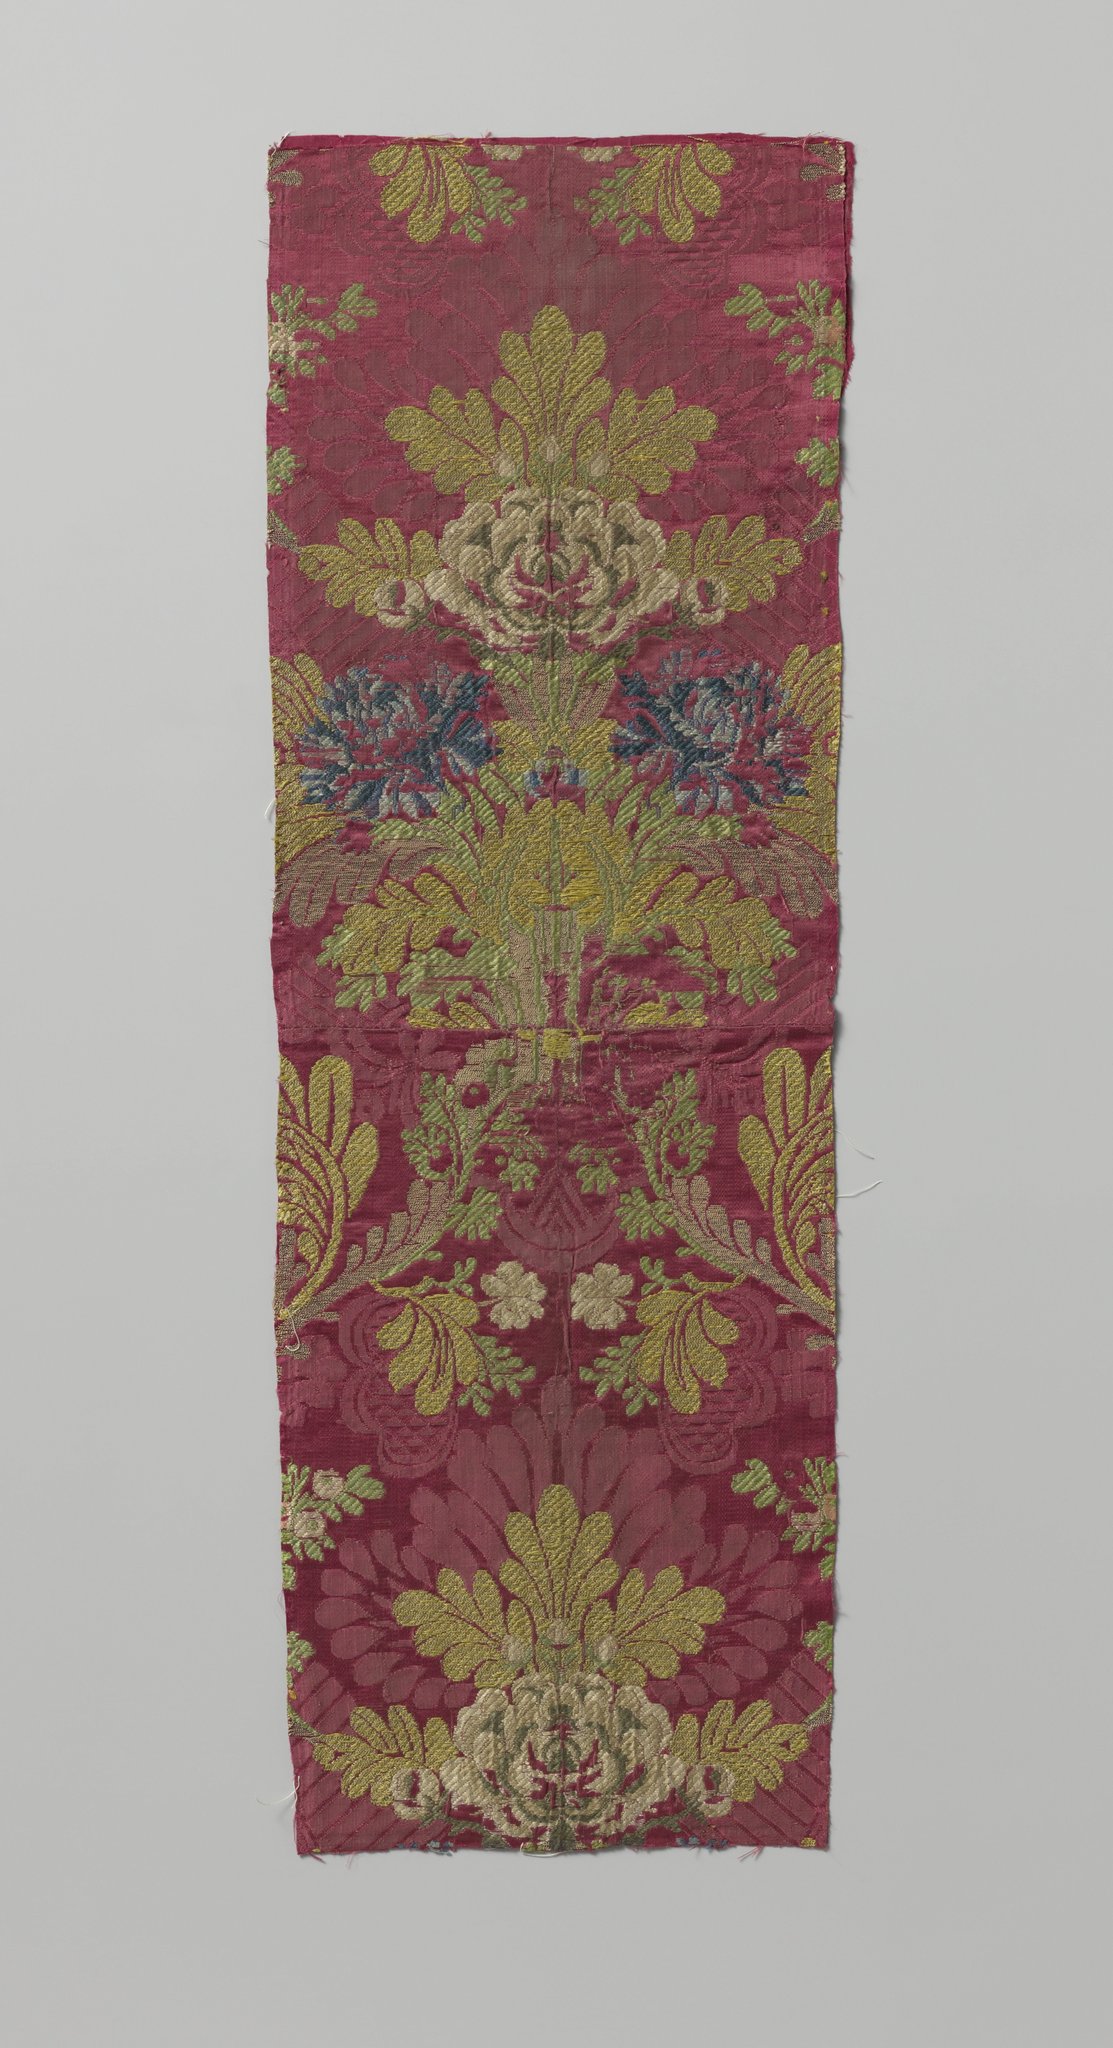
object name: zijdedamast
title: Fragment van een veelkleurig zijdedamast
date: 1740-1760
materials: silk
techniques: brocade, damask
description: Op een rode satijnen grond een symmetrische tak goud of zilver doorweven bladeren, twee blauwe anjers en een licht-zalmkleurige roos. Twee aan elkaar genaaide stukken.